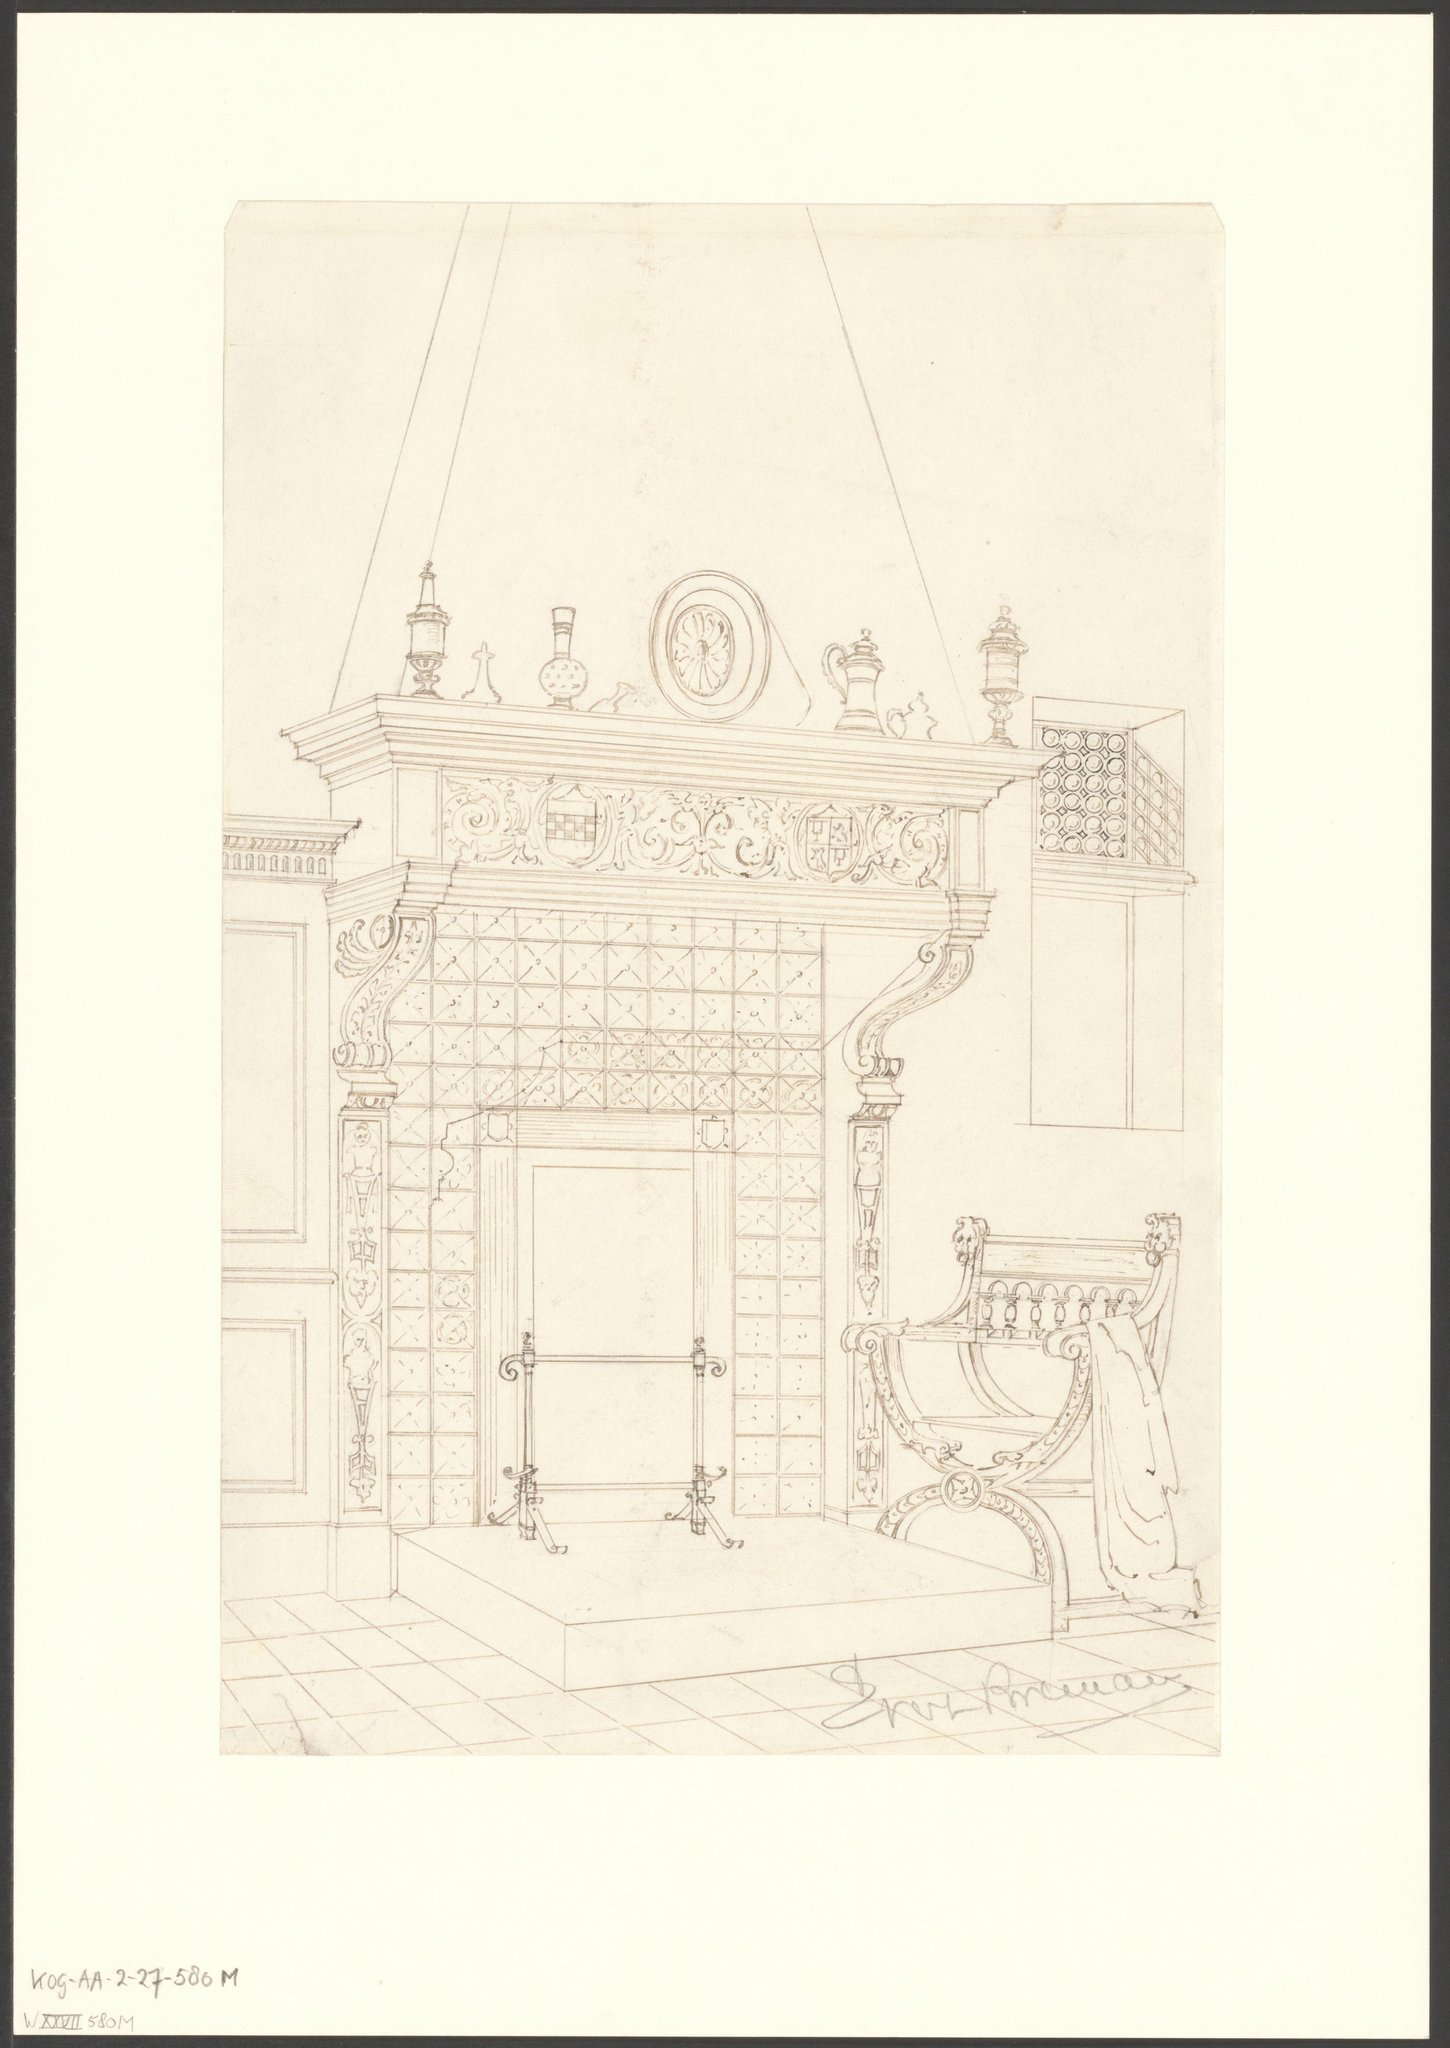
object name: drawing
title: Gezicht op een schouw in Oud-Holland tijdens de Wereldtentoonstelling voor het Hotel- en Reiswezen in 1895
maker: evert breman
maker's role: architect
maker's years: 1859-1926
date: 1894-1895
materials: ink, paper, pencil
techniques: pen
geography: amsterdam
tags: city-view in general; 'veduta', open hearth, fire-place, village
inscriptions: signature: ‘EvertBreman’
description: Tekening binnen de Atlas Van Eck ingedeeld op wijknummer 27.